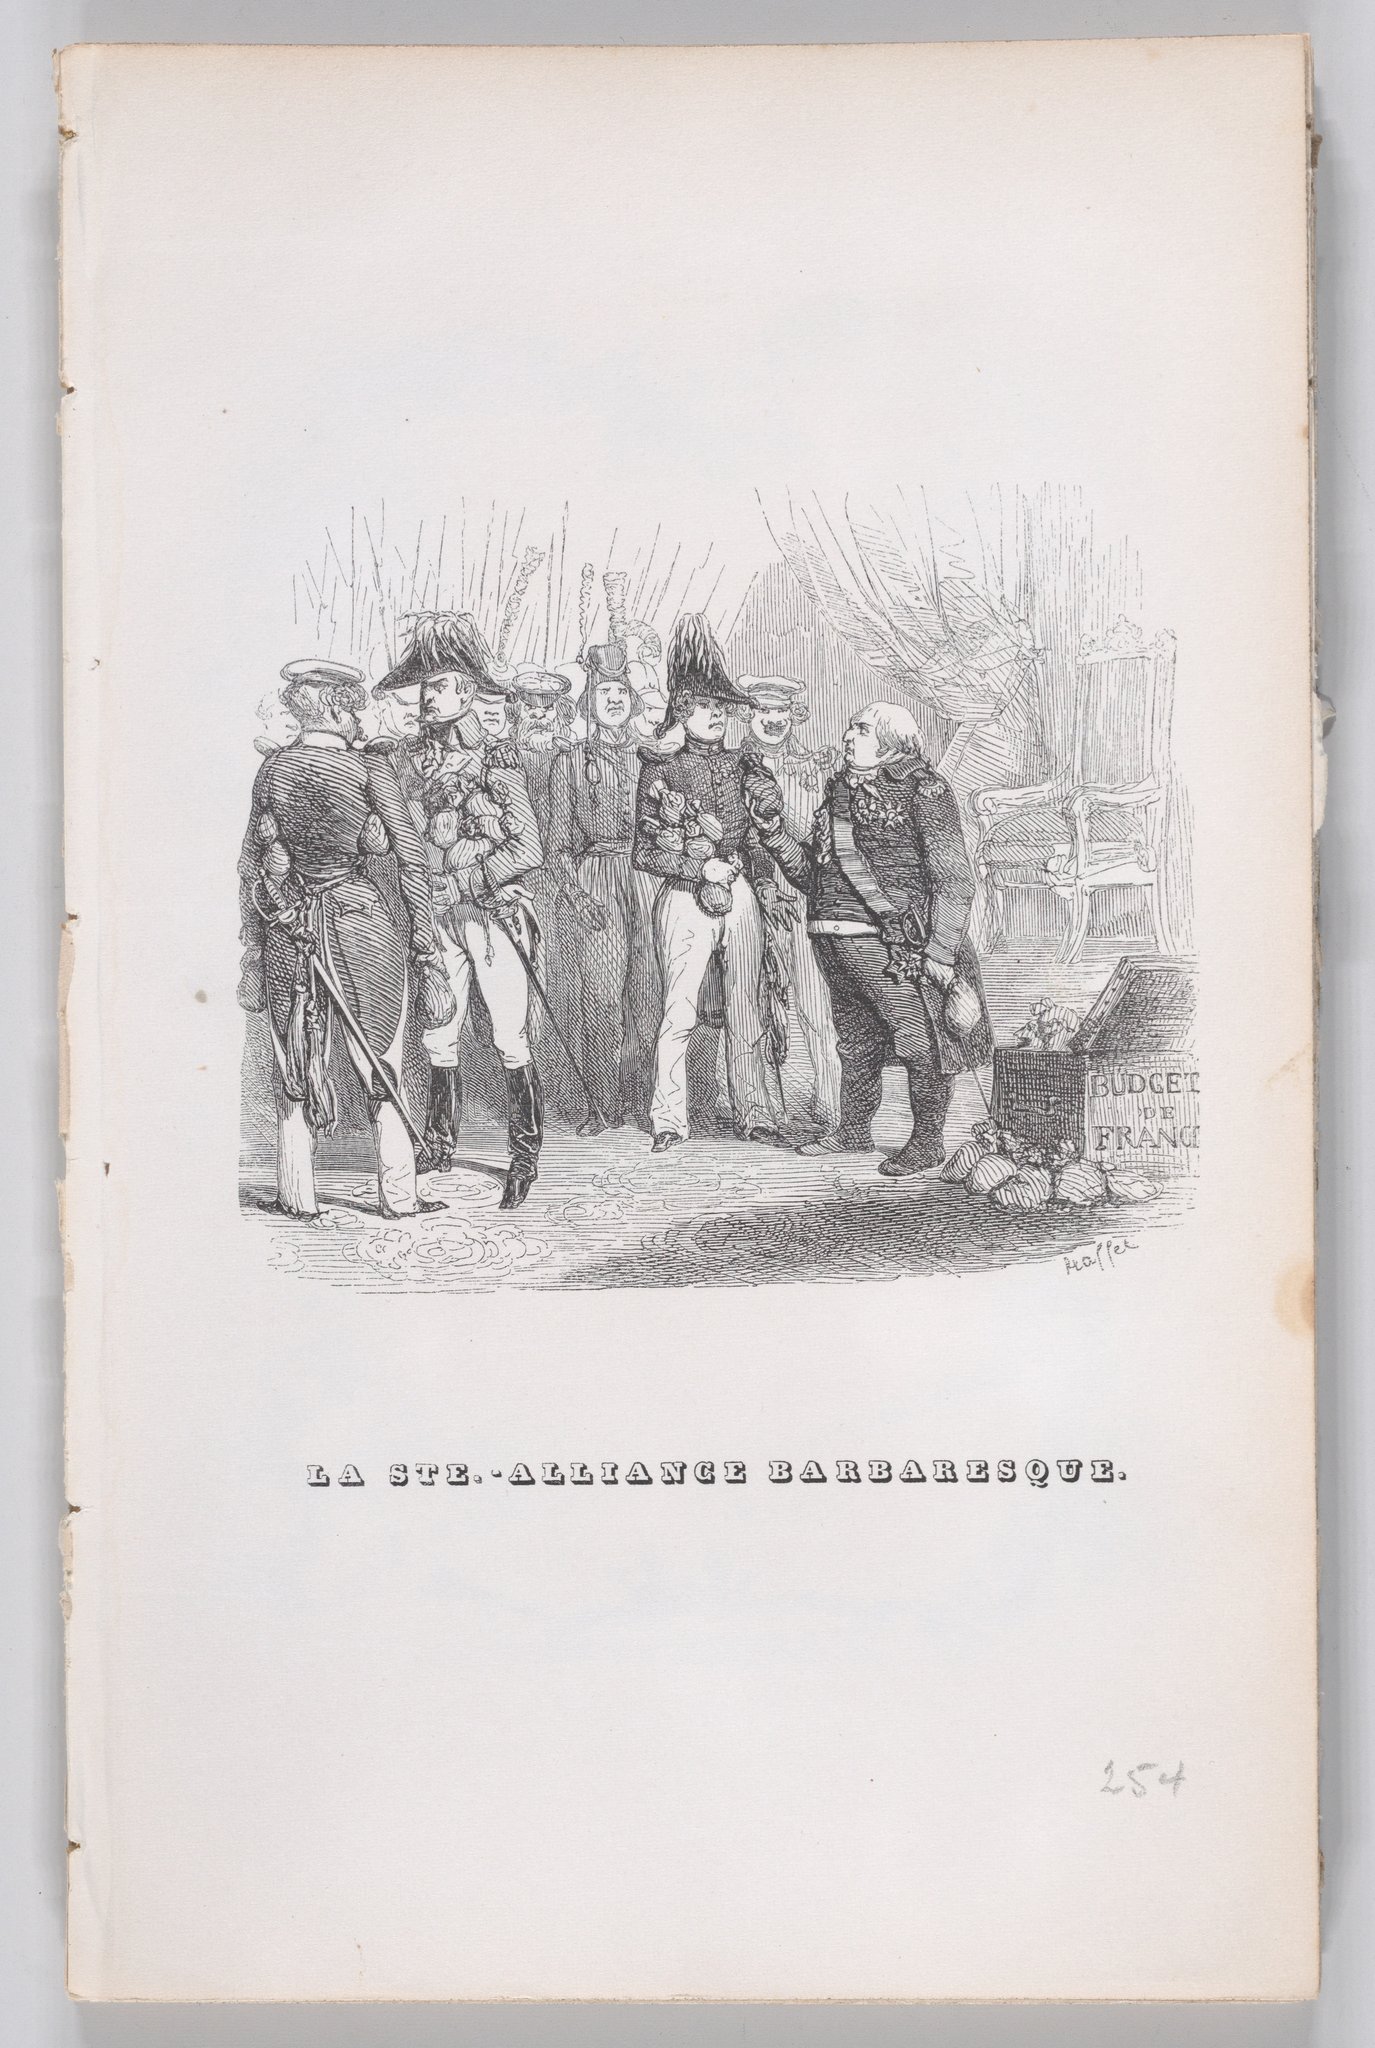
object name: print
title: The Barbaric Holy Alliance, from "The Complete Works of Béranger"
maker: j. j. grandville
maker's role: illustrator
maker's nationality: french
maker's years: 1803-1847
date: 1836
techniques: engraving